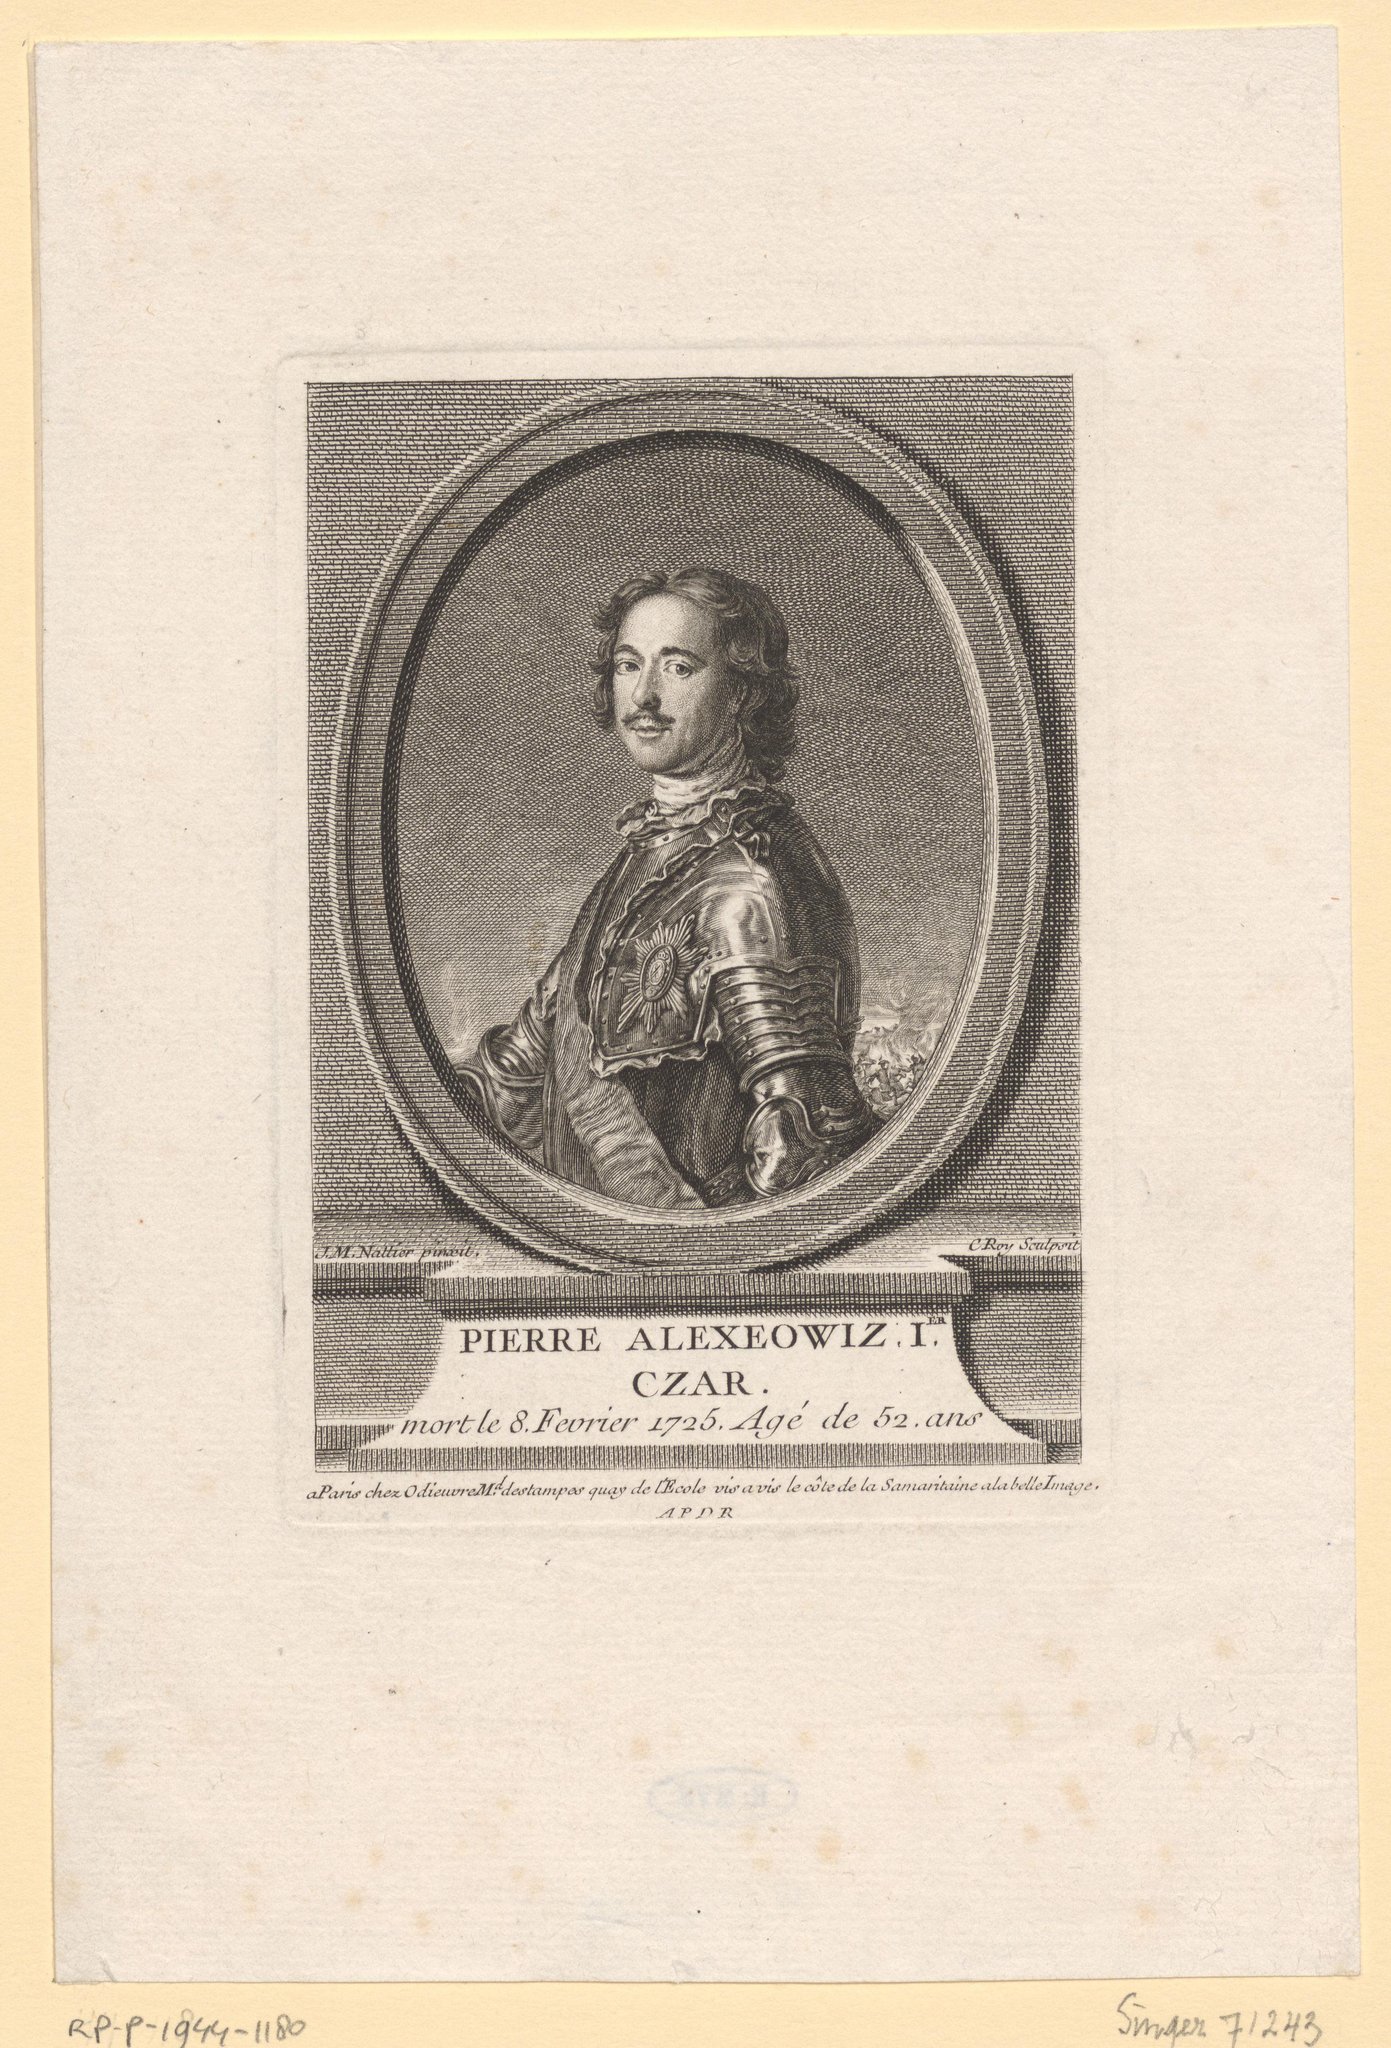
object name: print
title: Portret van Peter I de Grote, tsaar van Rusland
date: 1757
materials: paper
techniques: engraving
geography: paris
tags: peter i de grote (tsaar van rusland), armour, adult man, historical persons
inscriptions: collector's mark: Lugt 2228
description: Prent mogelijk uit: L'Europe illustré, contenant l'histoire abregée des souverains, des princes, des prélats, des ministres (...). Parijs: Le Breton, 1757, dl. 4.